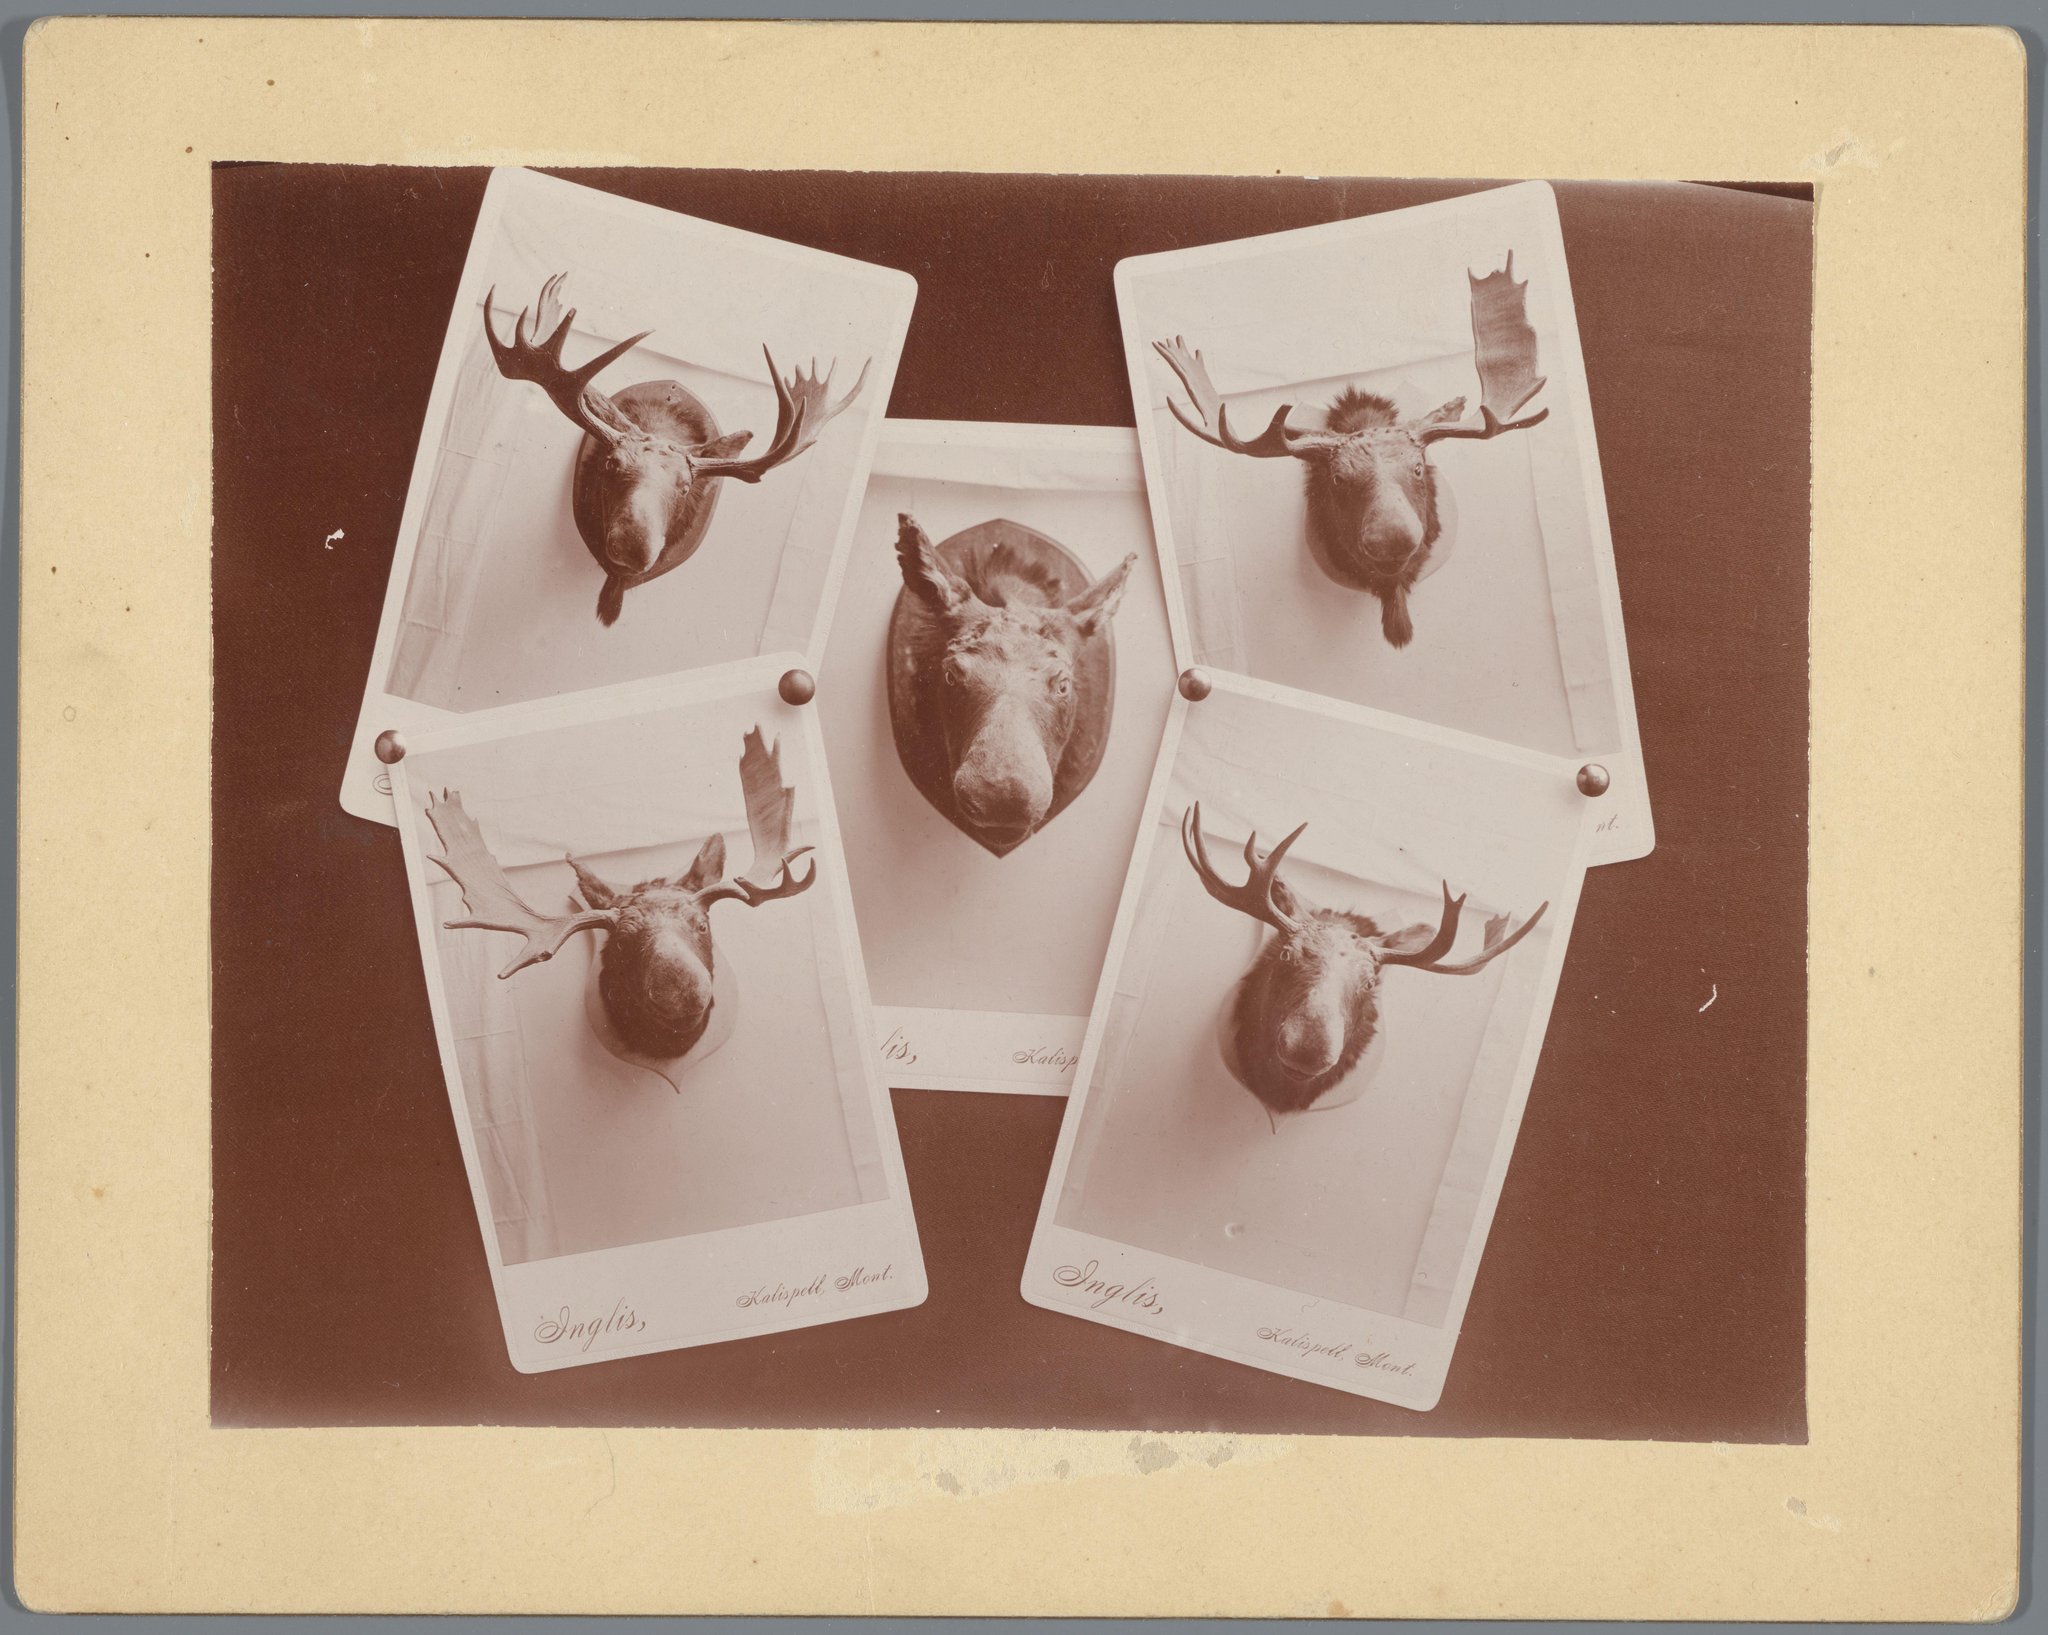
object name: photograph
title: Compositie van vijf foto's met geweien van elanden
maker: william inglis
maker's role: fotograaf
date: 1900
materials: photographic support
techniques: photography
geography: kalispell